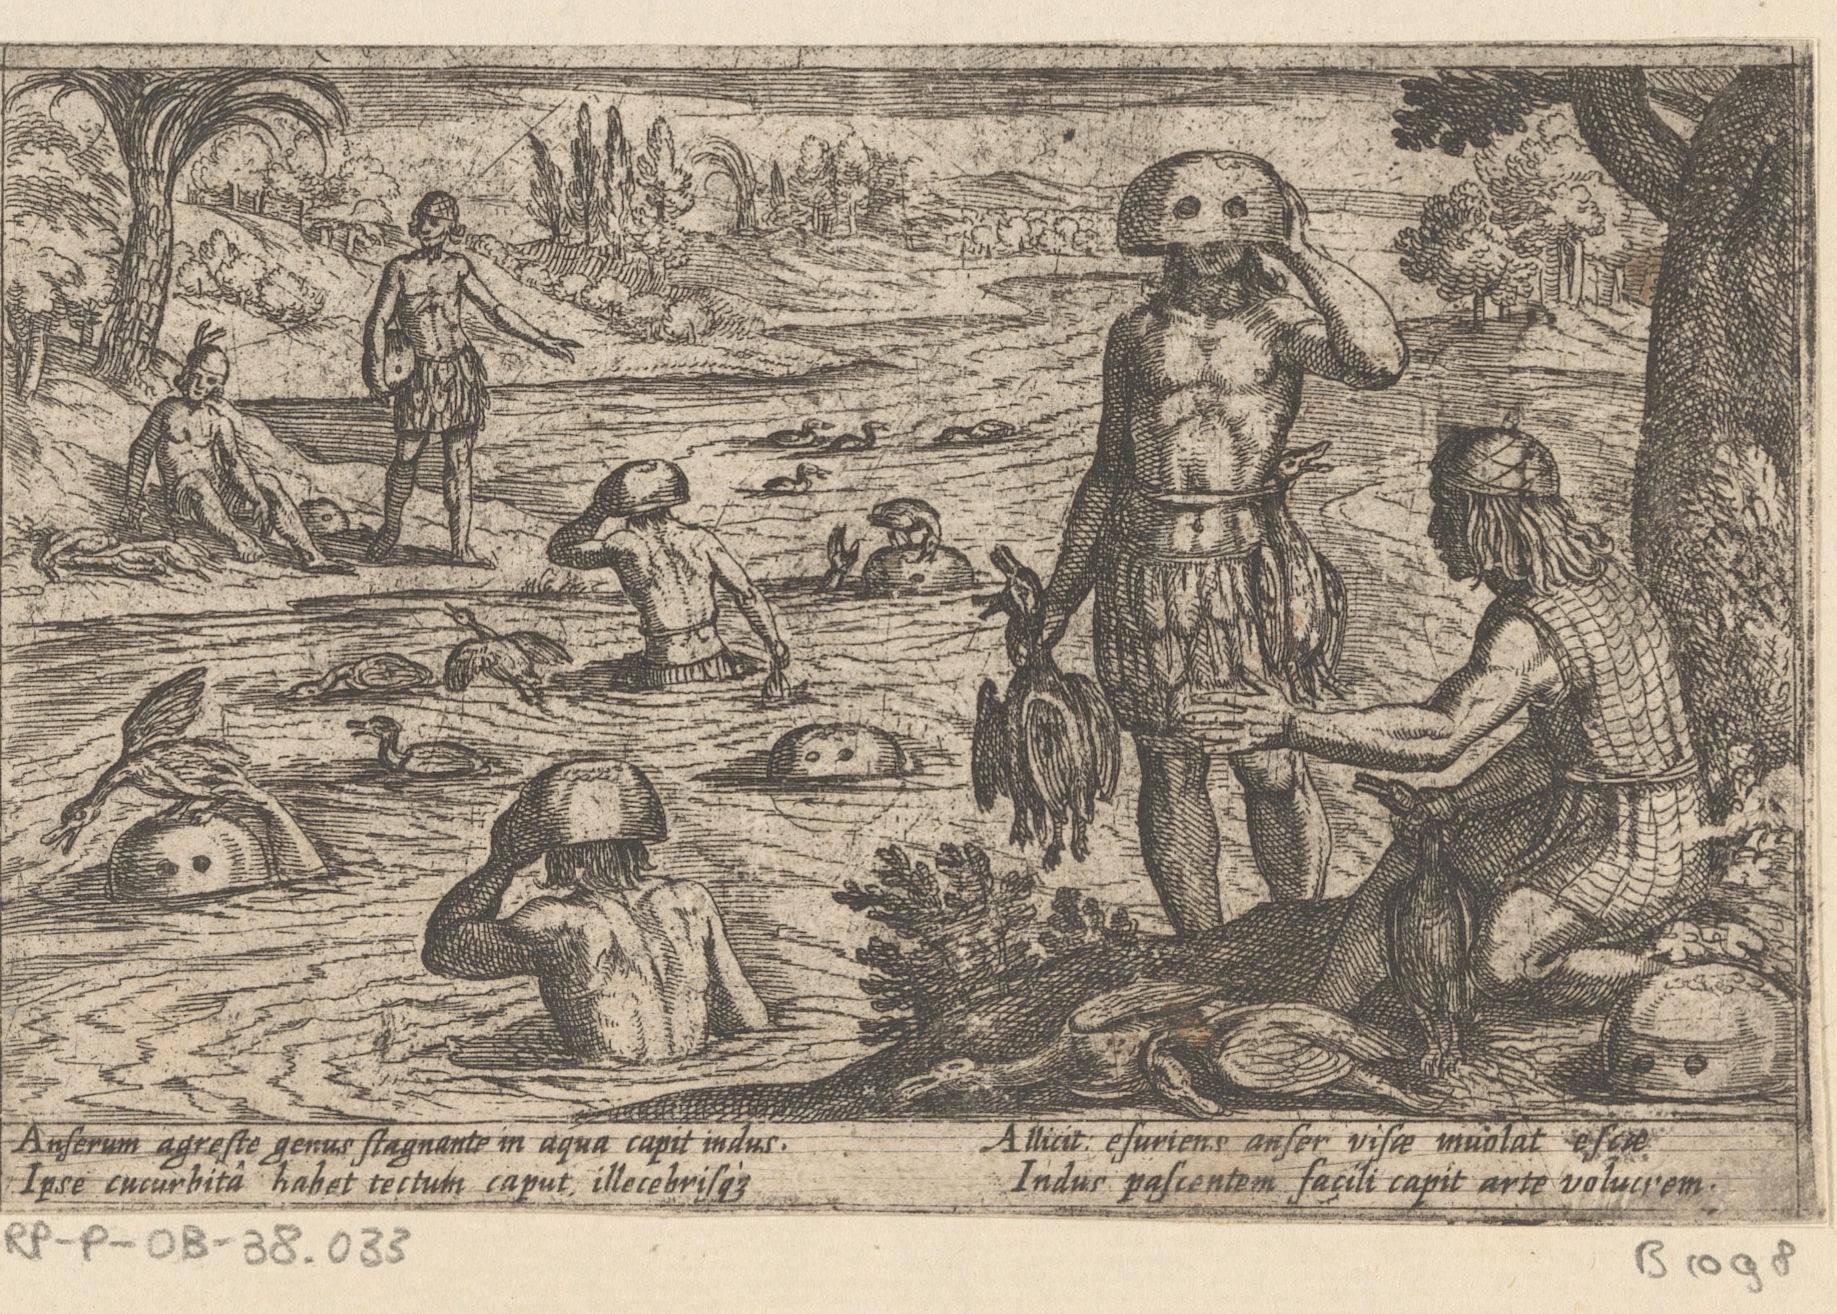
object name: print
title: Venationes Ferarum, Avium, Piscium Pugnae bestiariorum: et mutuae bestiarum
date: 1602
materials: paper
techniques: etching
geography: italy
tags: water-birds: goose, hunter, hunters hunting (n.b.: in 1988-1990 this notation denoted the concept of 43c11421 'hunters resting during the hunt'), fisherman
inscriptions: collector's mark: Lugt 240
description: Vissers met manden met kijkgaten op hun hoofden zitten in het water en lokken ganzen. Wanneer de ganzen op de manden kruipen, worden ze gegrepen door de vissers. Tekst in het Latijn in ondermarge.